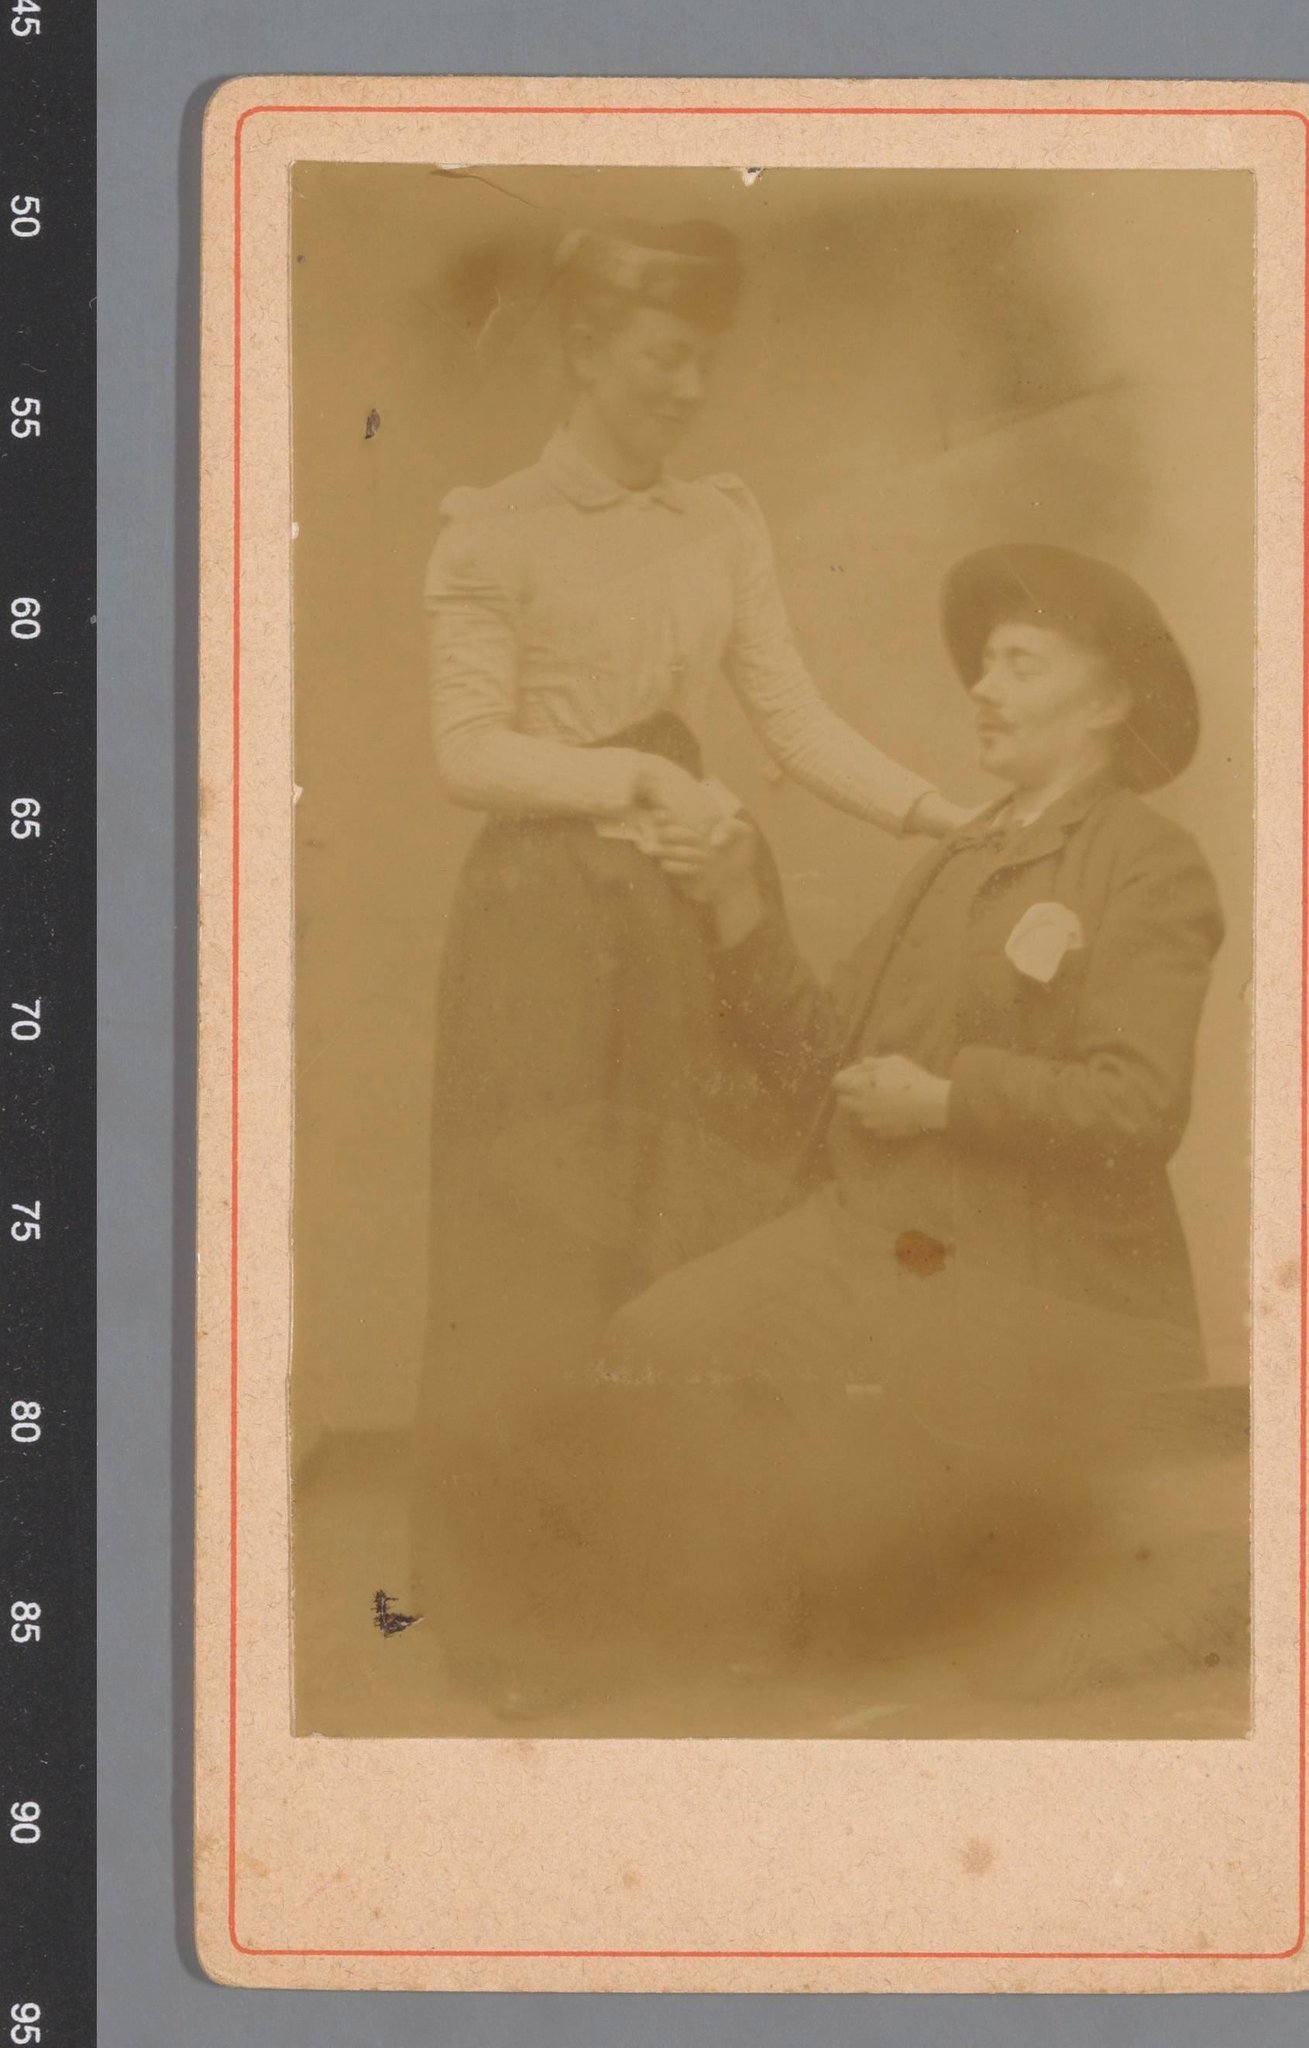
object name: photograph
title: Portret van een onbekende man en een onbekende vrouw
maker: Anonymous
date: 1892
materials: cardboard, photographic support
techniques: gelatin silver print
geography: netherlands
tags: historical persons not known by name - bb - woman, historical persons not known by name